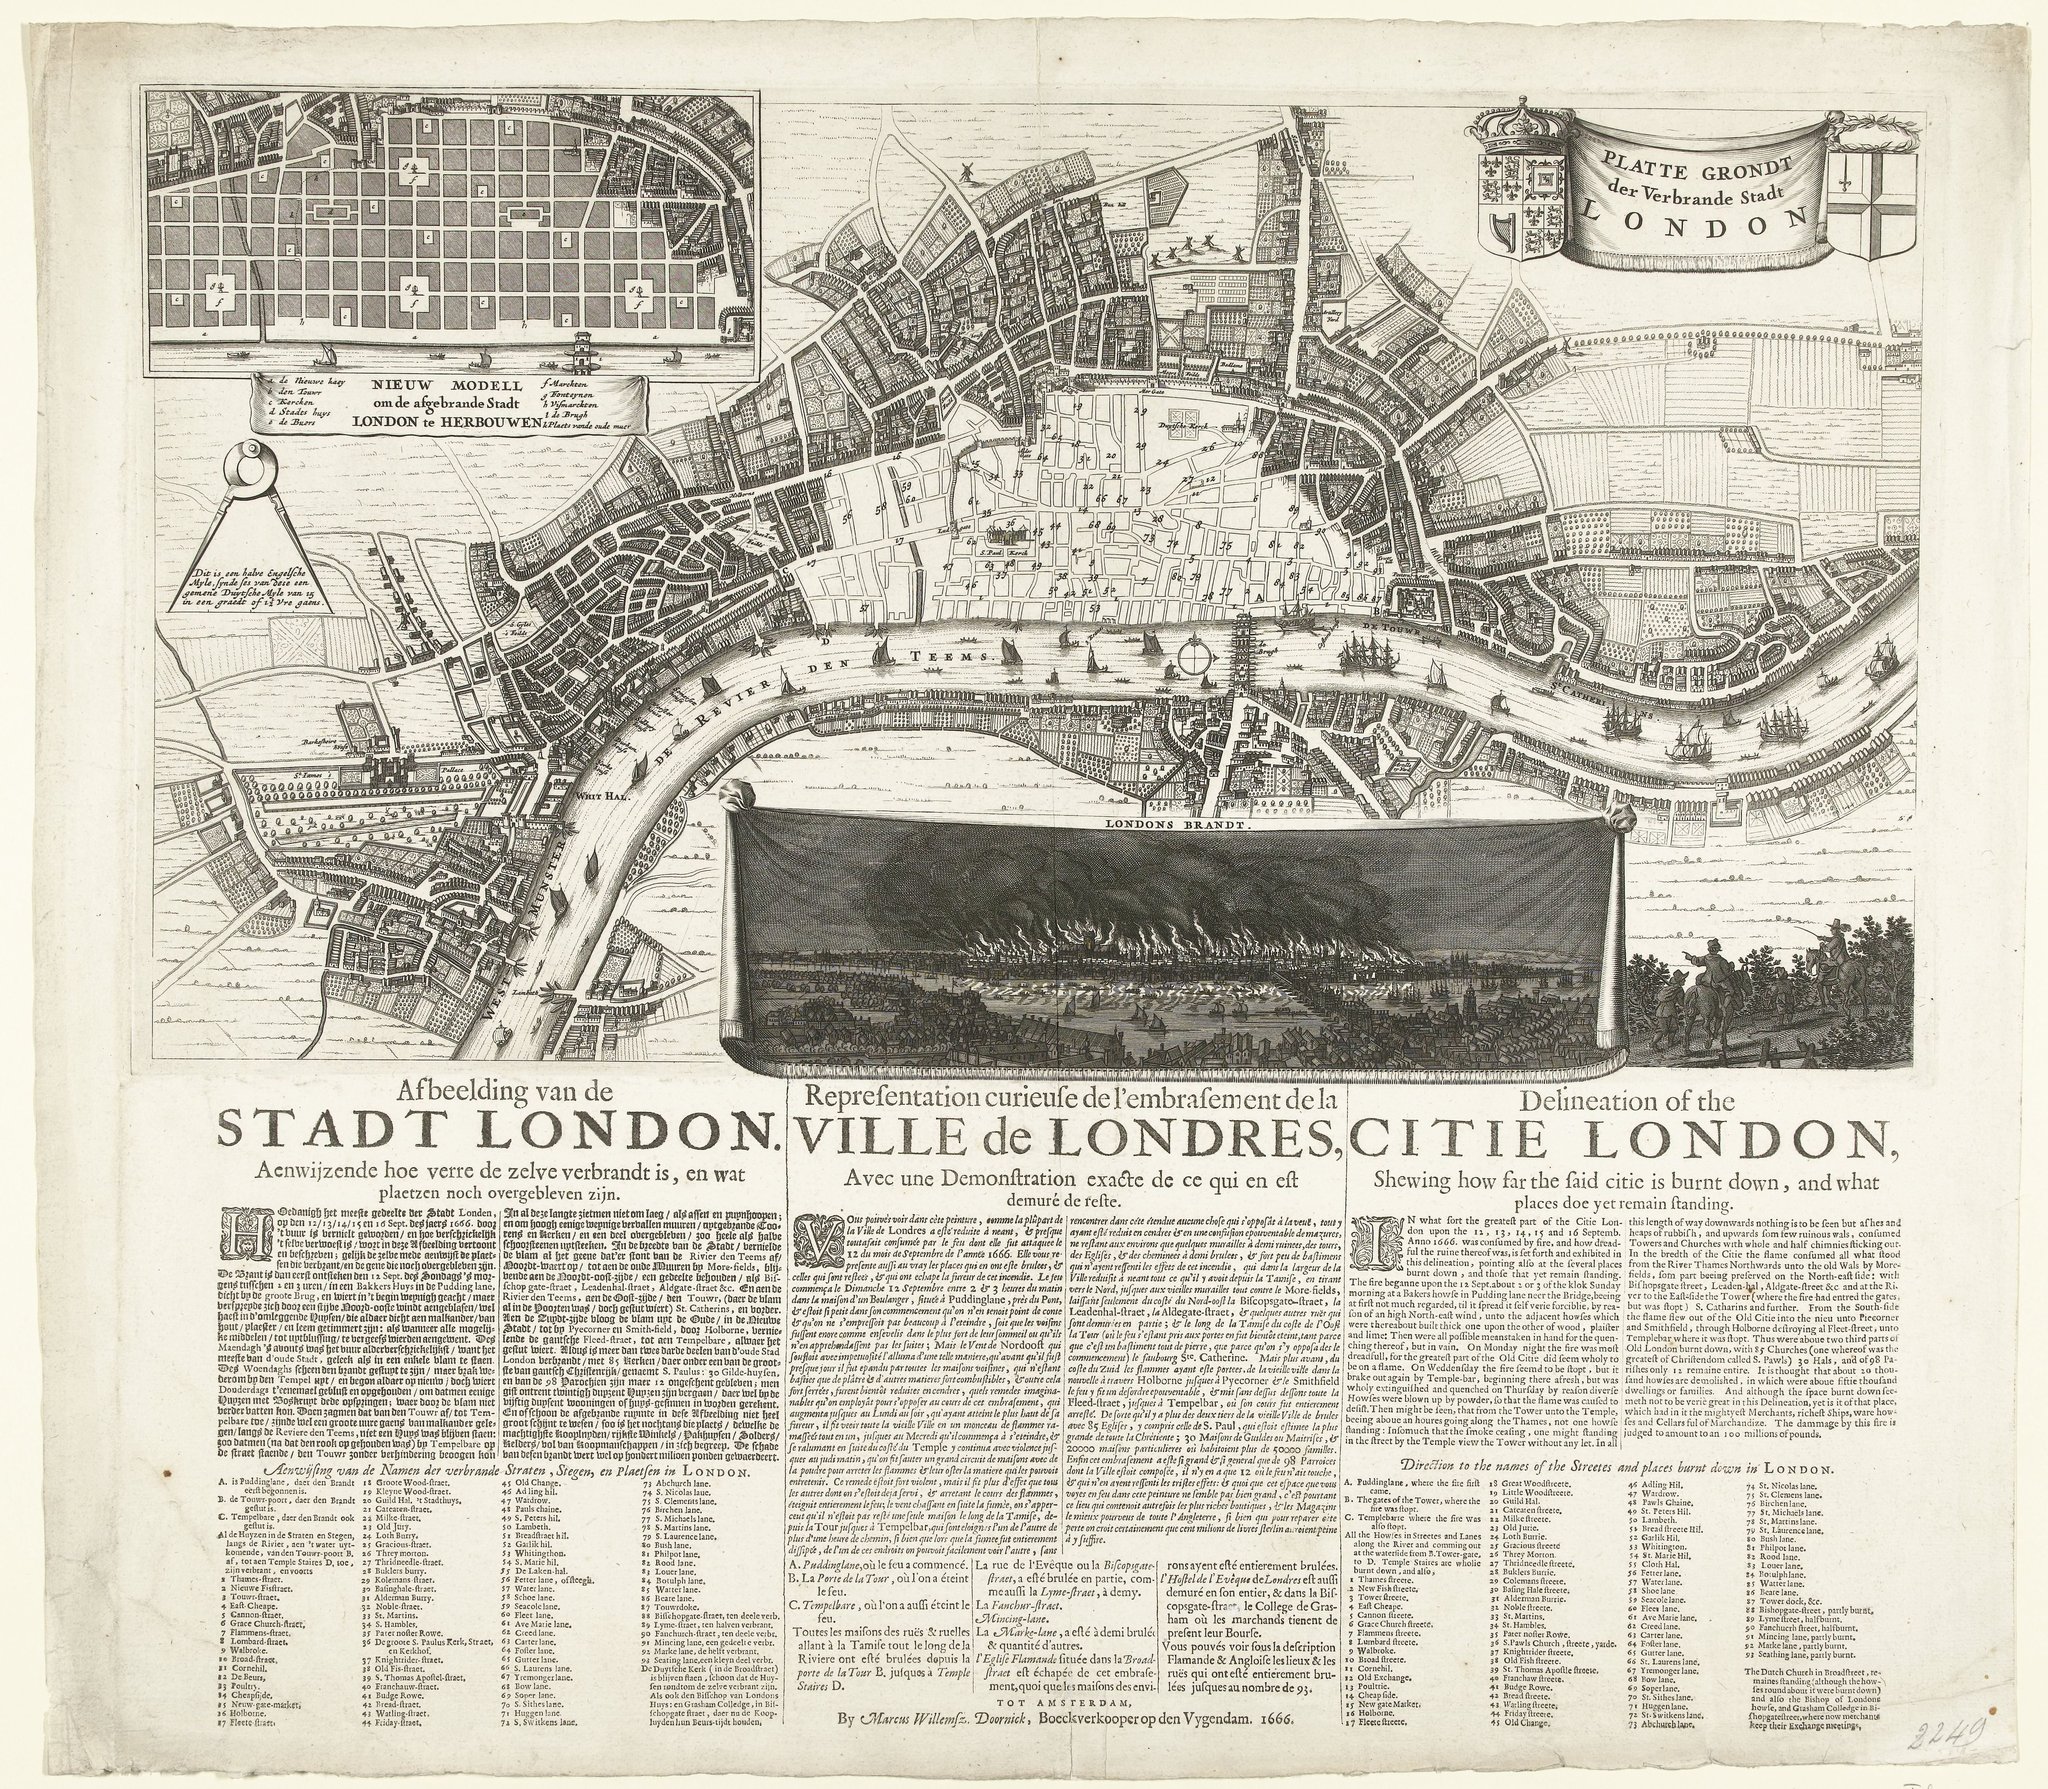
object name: print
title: Afbeelding van de Stadt London. Aenwijzende hoe verre de zelve verbrandt is, en wat plaetzen noch overgebleven zijn / Representation curieuse de l'embrasement de la Ville de Londres (...) / Delineation of the Citie London (...)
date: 1666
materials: paper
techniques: engraving, etching, letterpress printing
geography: amsterdam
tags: maps of cities, london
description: Plattegrond van Londen waarop is aangegeven het deel van de stad dat verwoest is tijdens de grote brand van 12-15 september 1666. Linksboven een inzet met het plan voor de herbouw. Onderaan een inzet met een gezicht op de brandende stad bij nacht. Onderaan teksten in 2 kolommen in het Nederlands, 2 kolommen in het Frans en 2 kolommen in het Engels met een beschrijving van de gebeurtenissen en een lijst van de verbrande straten en plaatsen binnen Londen.